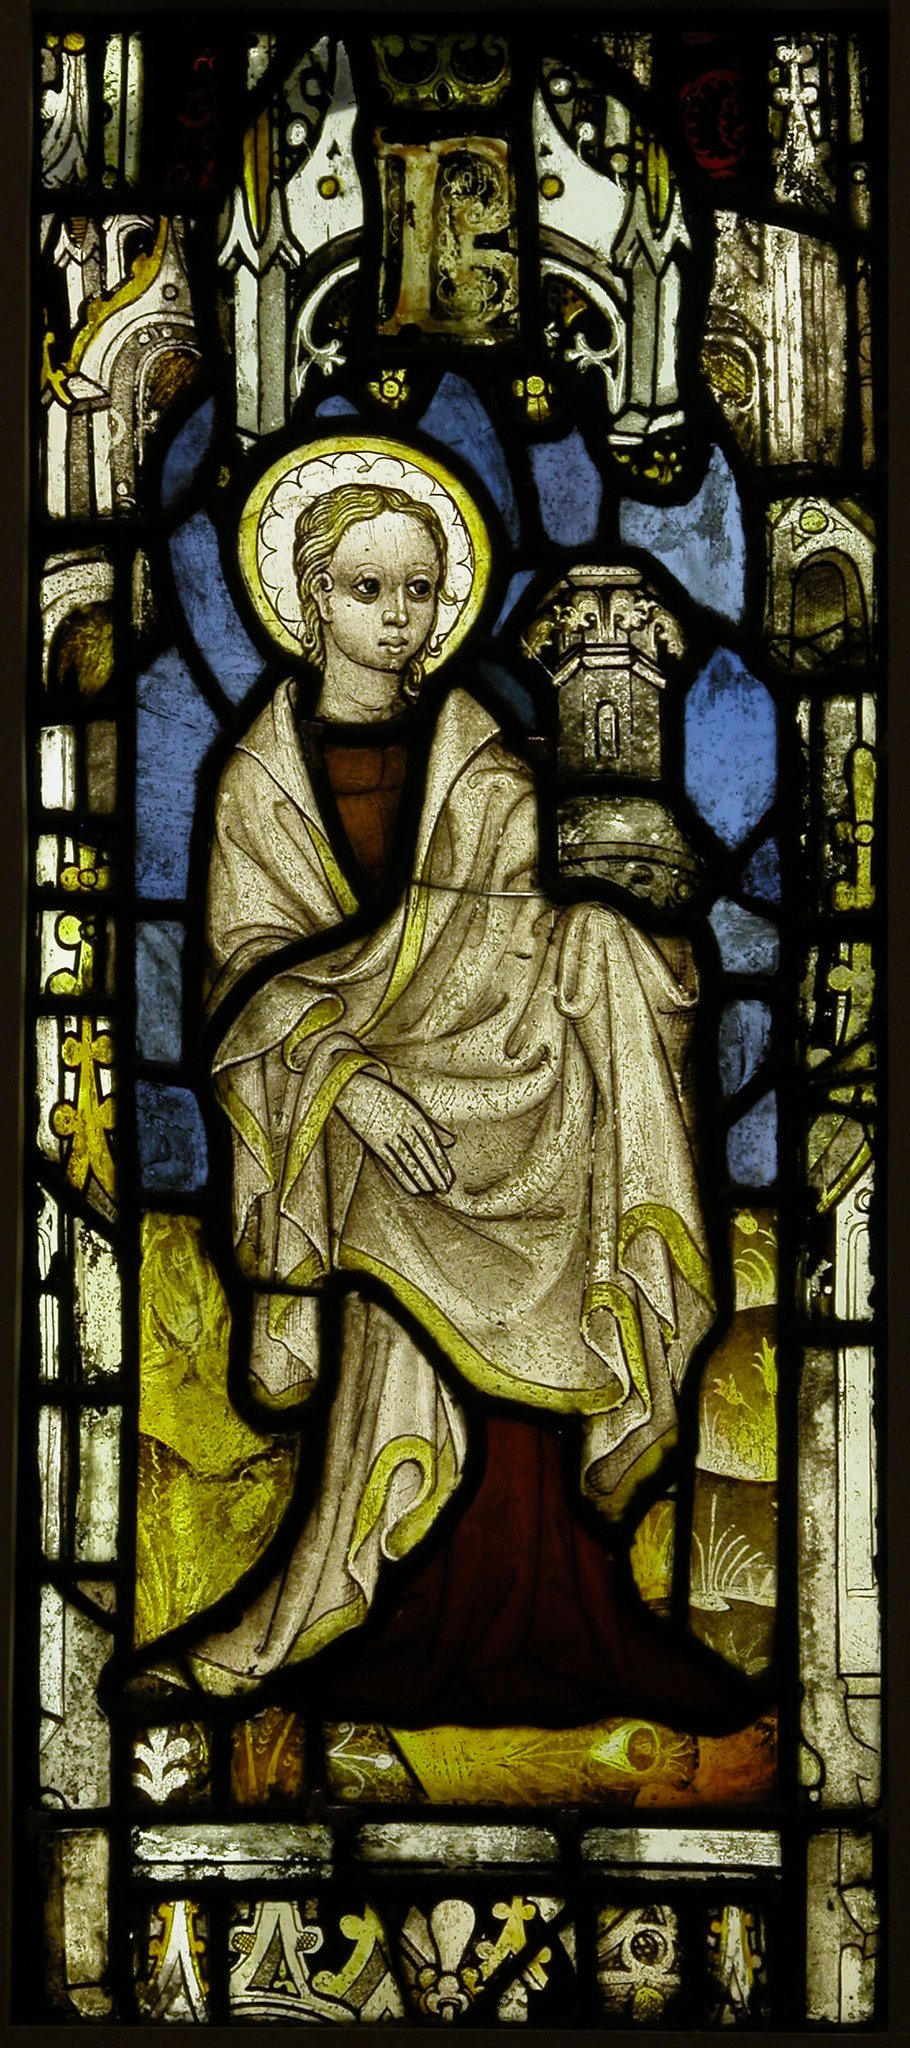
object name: panel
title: Female Saint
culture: british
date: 1450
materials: glass, metal, paint, pigment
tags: women,saints